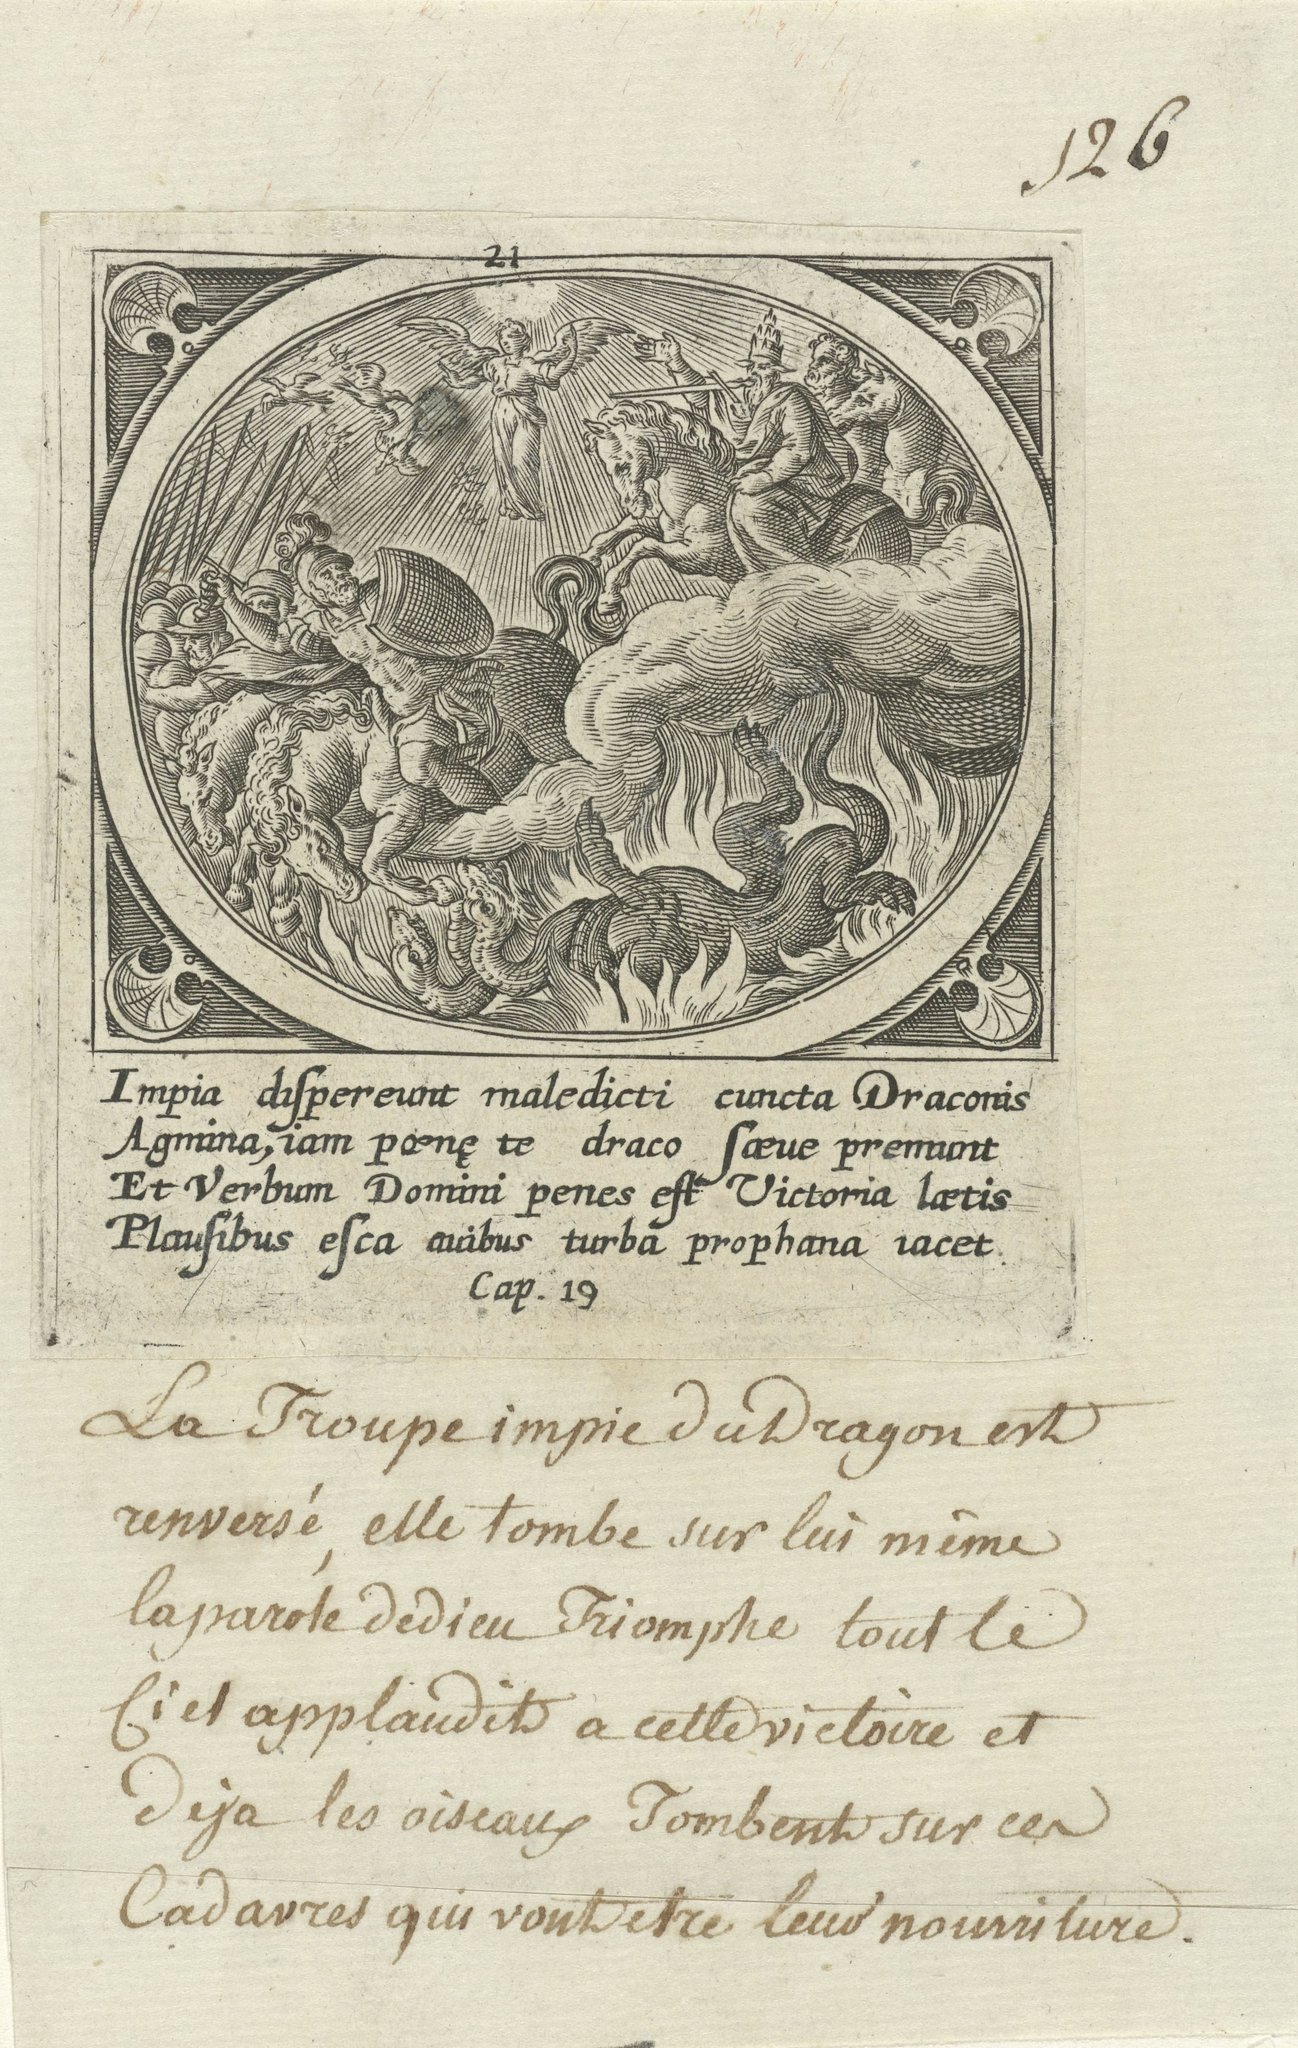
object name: print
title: Icones Revelationum S Johs Evangeliste in Pathmo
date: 1585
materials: paper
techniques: engraving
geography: antwerp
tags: the beast and the false prophet conquered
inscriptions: collector's mark: Lugt 2228, inscription: ‘126’, inscription: ‘La troupe [...] nourri lure.’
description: Een engel staat midden in de zon en roept naar de vogels. Het hemelse leger, aangevoerd door een ruiter met pauselijke mijter en een zwaard in zijn mond, strijdt tegen het aardse leger. Het beest gaat ten onder in een vuurpoel. In de marge een vierregelig onderschrift in het Latijn. Eenentwintigste prent uit een serie van vierentwintig met de openbaring van Johannes op Patmos.